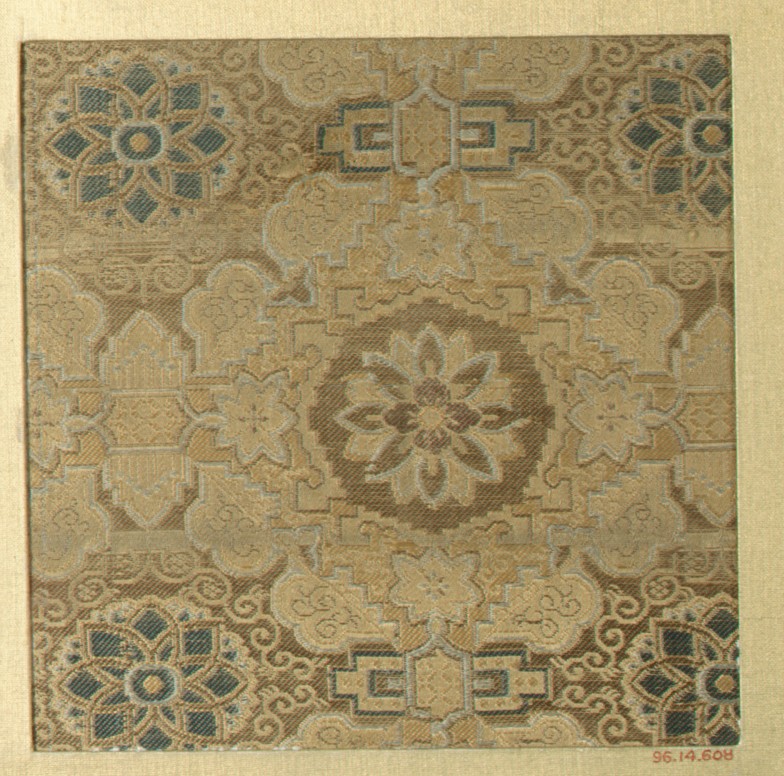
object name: piece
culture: japanese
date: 1701-1900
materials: silk